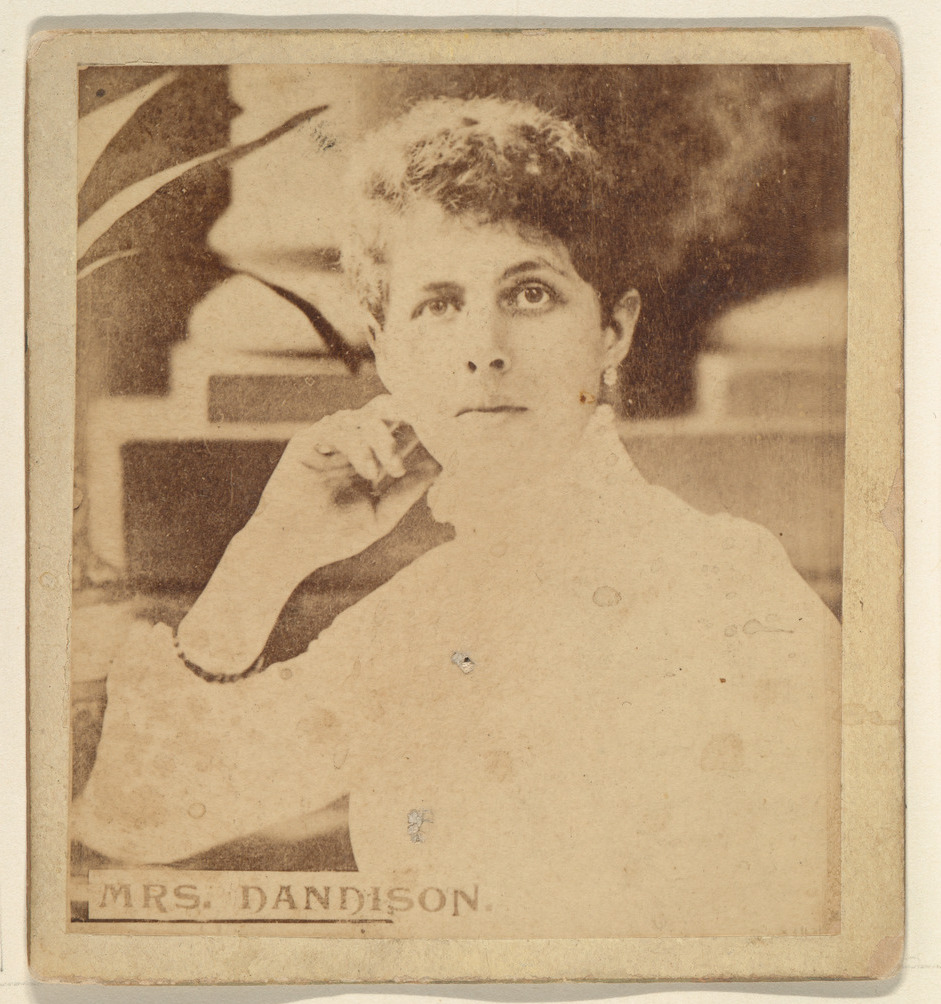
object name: photograph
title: Mrs. Dandison, from the Actresses series (N246), Type 2, issued by Kinney Brothers to promote Sporting Extra Cigarettes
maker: kinney brothers tobacco company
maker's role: publisher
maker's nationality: american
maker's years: 1869-2011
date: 1890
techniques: albumen silver print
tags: portraits,women,actresses